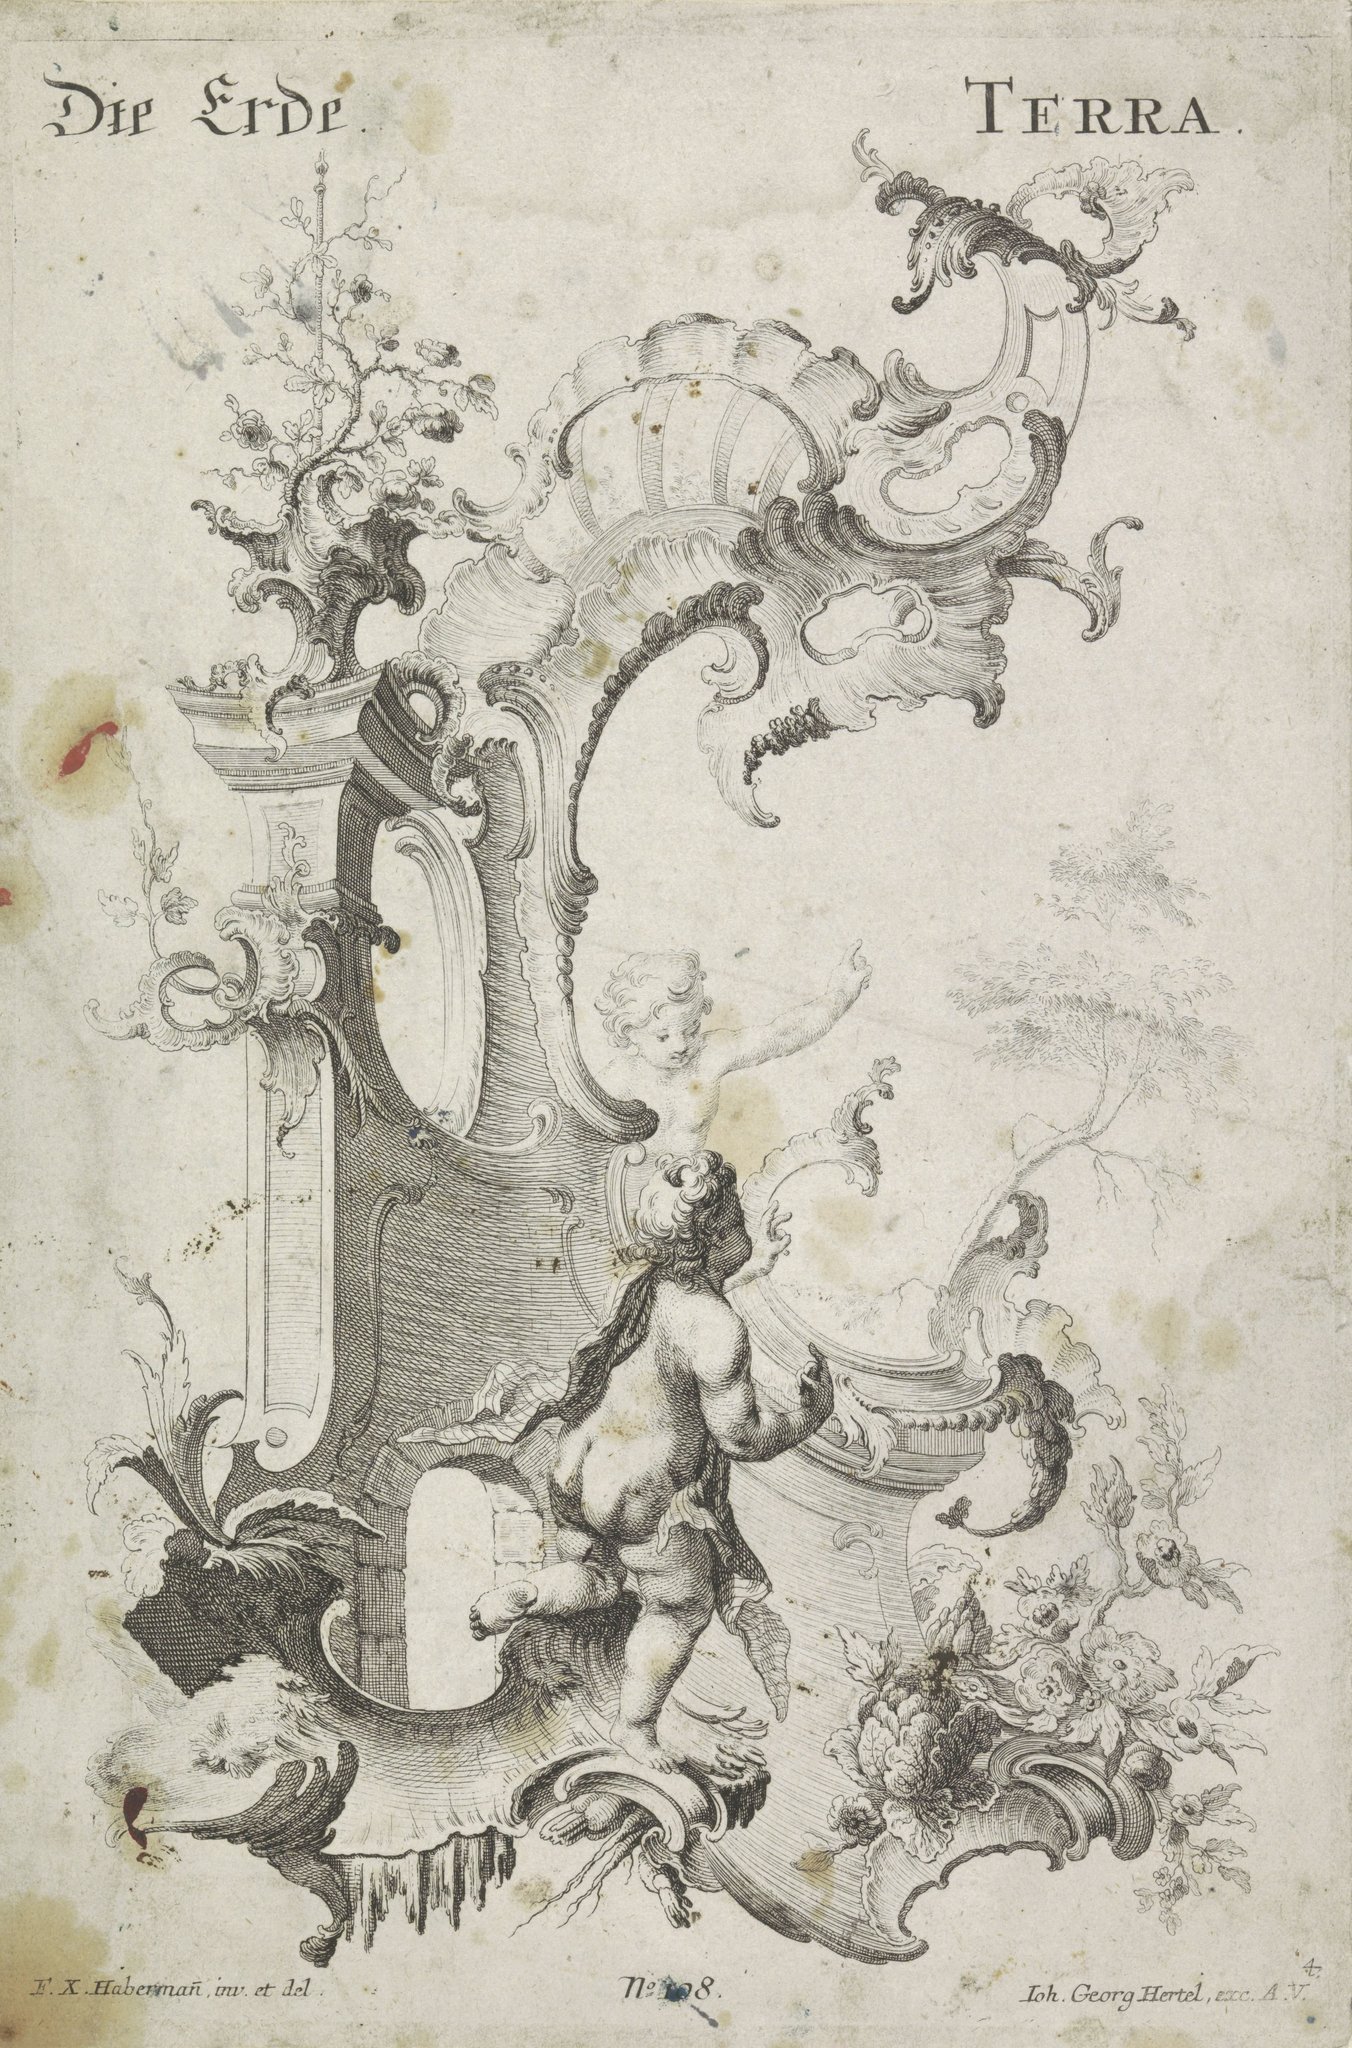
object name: print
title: De elementen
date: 1731-1775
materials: paper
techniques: etching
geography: augsburg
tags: rocaille ornament, earth (one of the four elements), cupids: 'amores', 'amoretti', 'putti'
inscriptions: collector's mark: Lugt 2760, collector's mark: Lugt 2228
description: In rocaille omraming het element aarde, bloemen en twee putti. Uitgeversnummer 108.